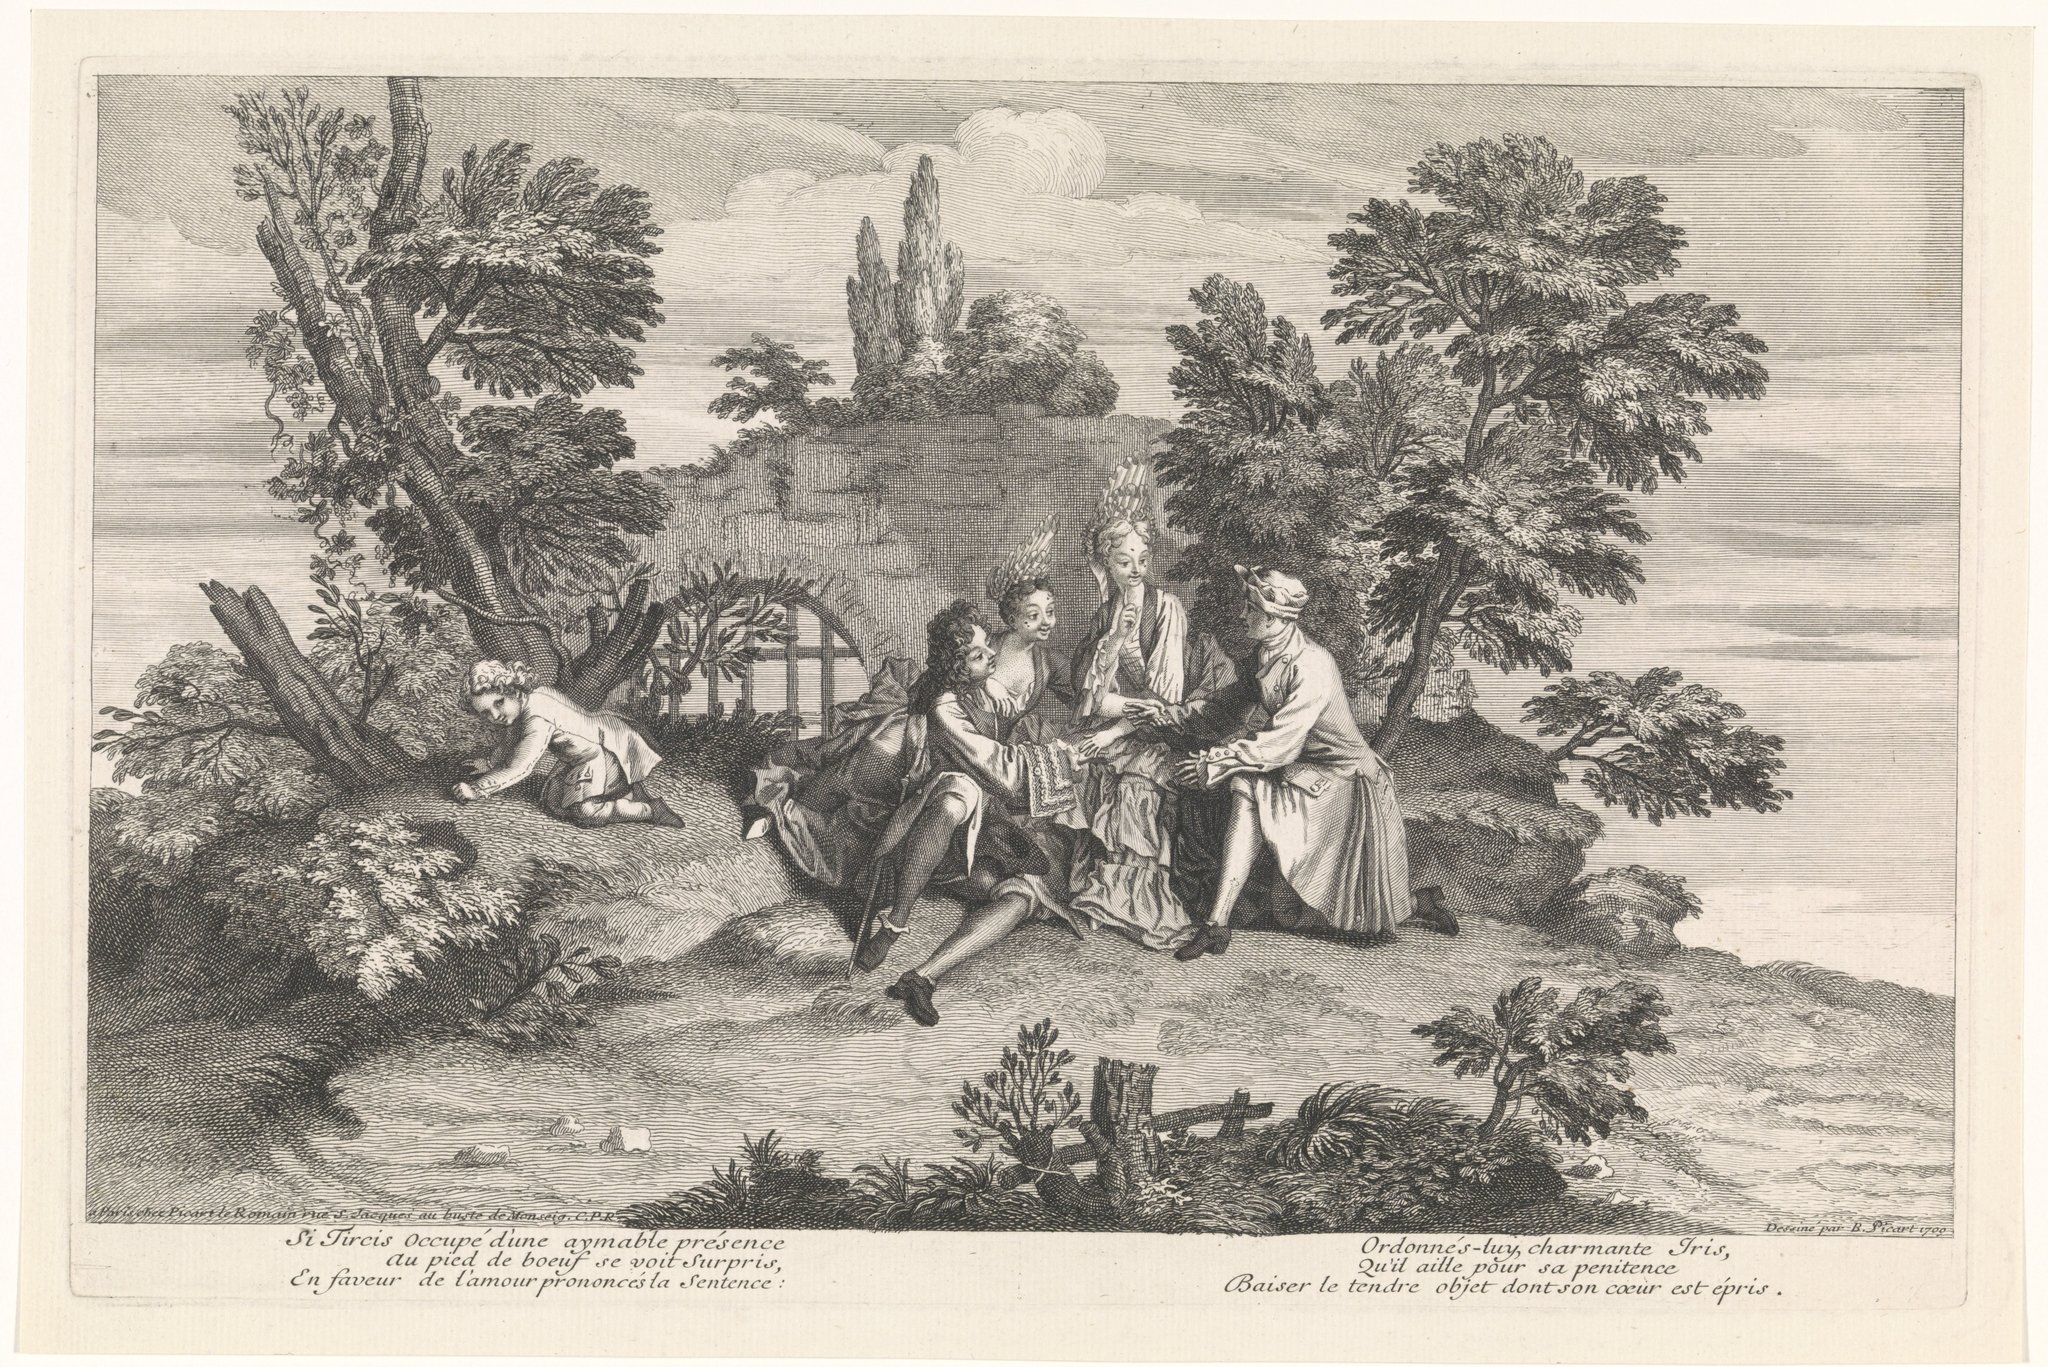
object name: print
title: Elegant gezelschap speelt het spel Pied de Boeuf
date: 1709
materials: paper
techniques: engraving, etching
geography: paris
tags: party games with erotic implications, e.g.: kissing contest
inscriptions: collector's mark: Lugt 240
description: Een gezelschap van twee mannen en twee vrouwen speelt het spel Pied de Boeuf. Het was oorspronkelijk een kinderspel waarbij de spelers hun handen op elkaar leggen. In de marge een zesregelig gedicht, in twee kolommen, in het Frans.